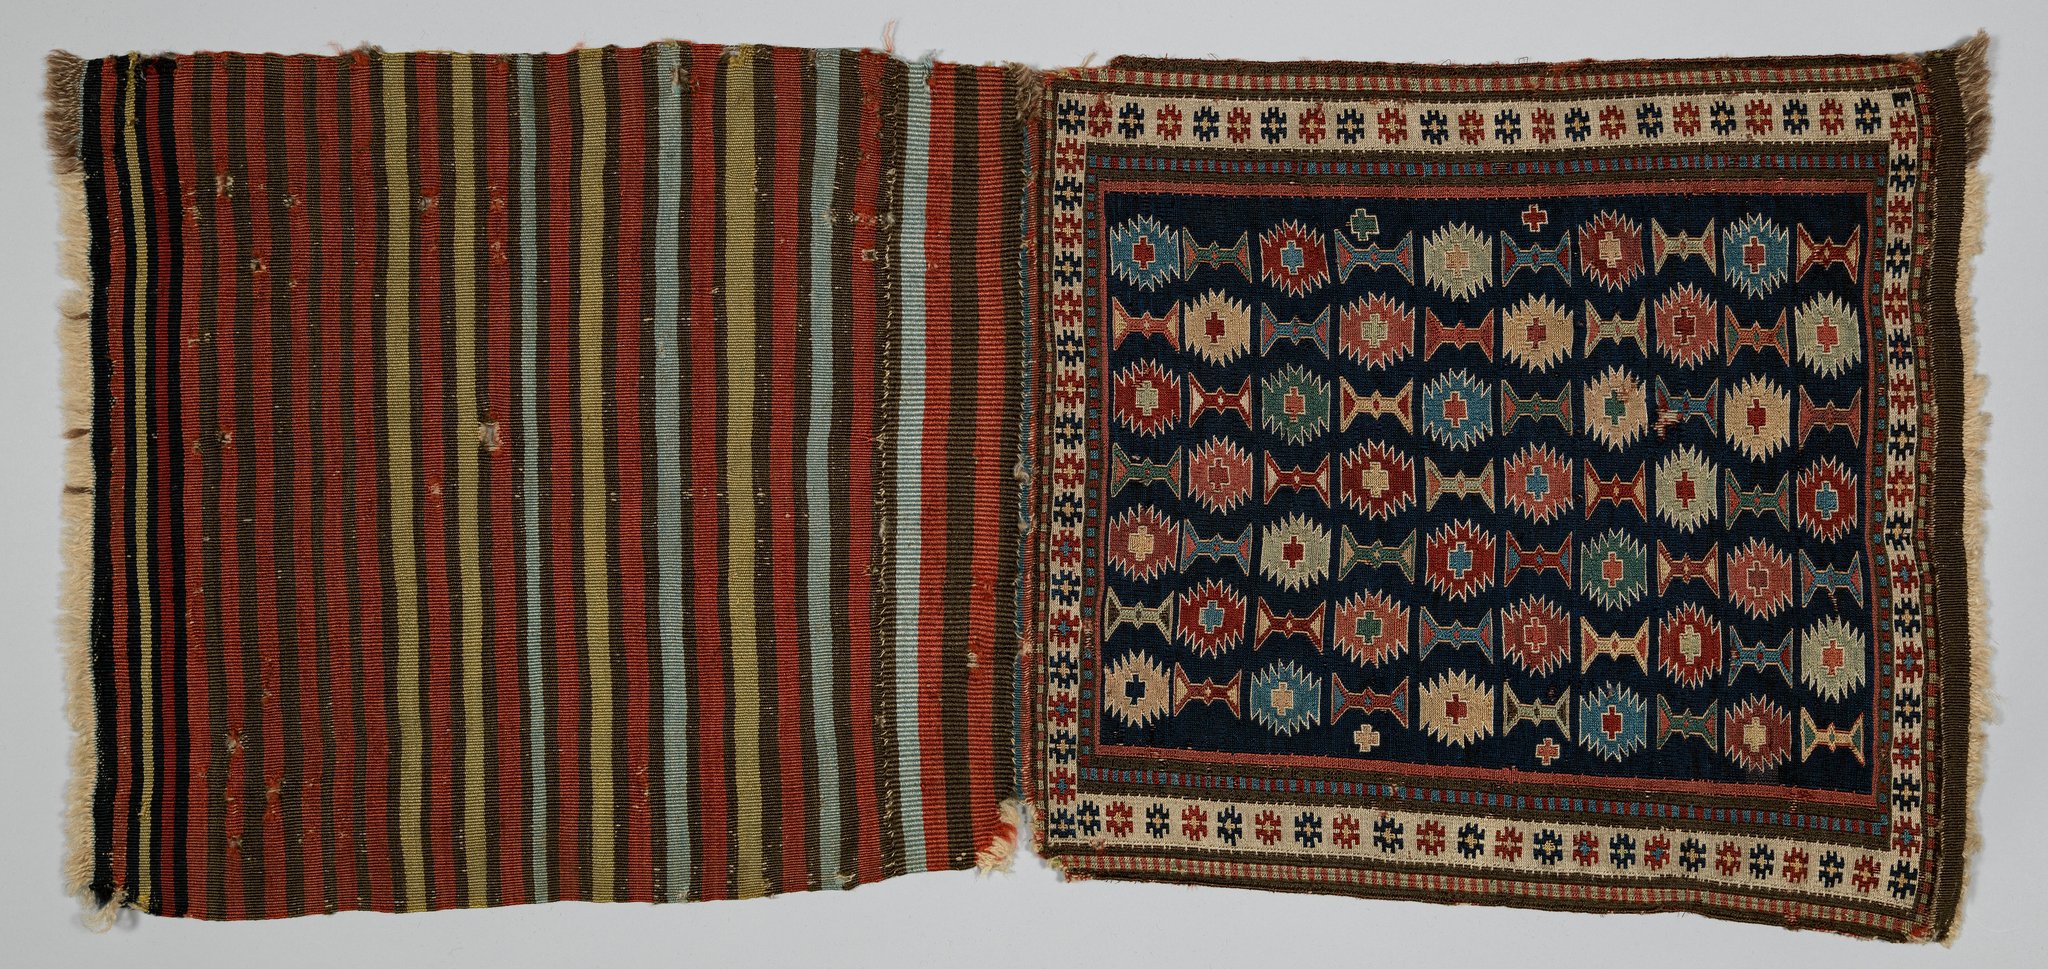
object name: saddle bag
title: Face from Half of Double Saddle Bag (Khorjin)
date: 1850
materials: wool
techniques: brocade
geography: northwestern iran